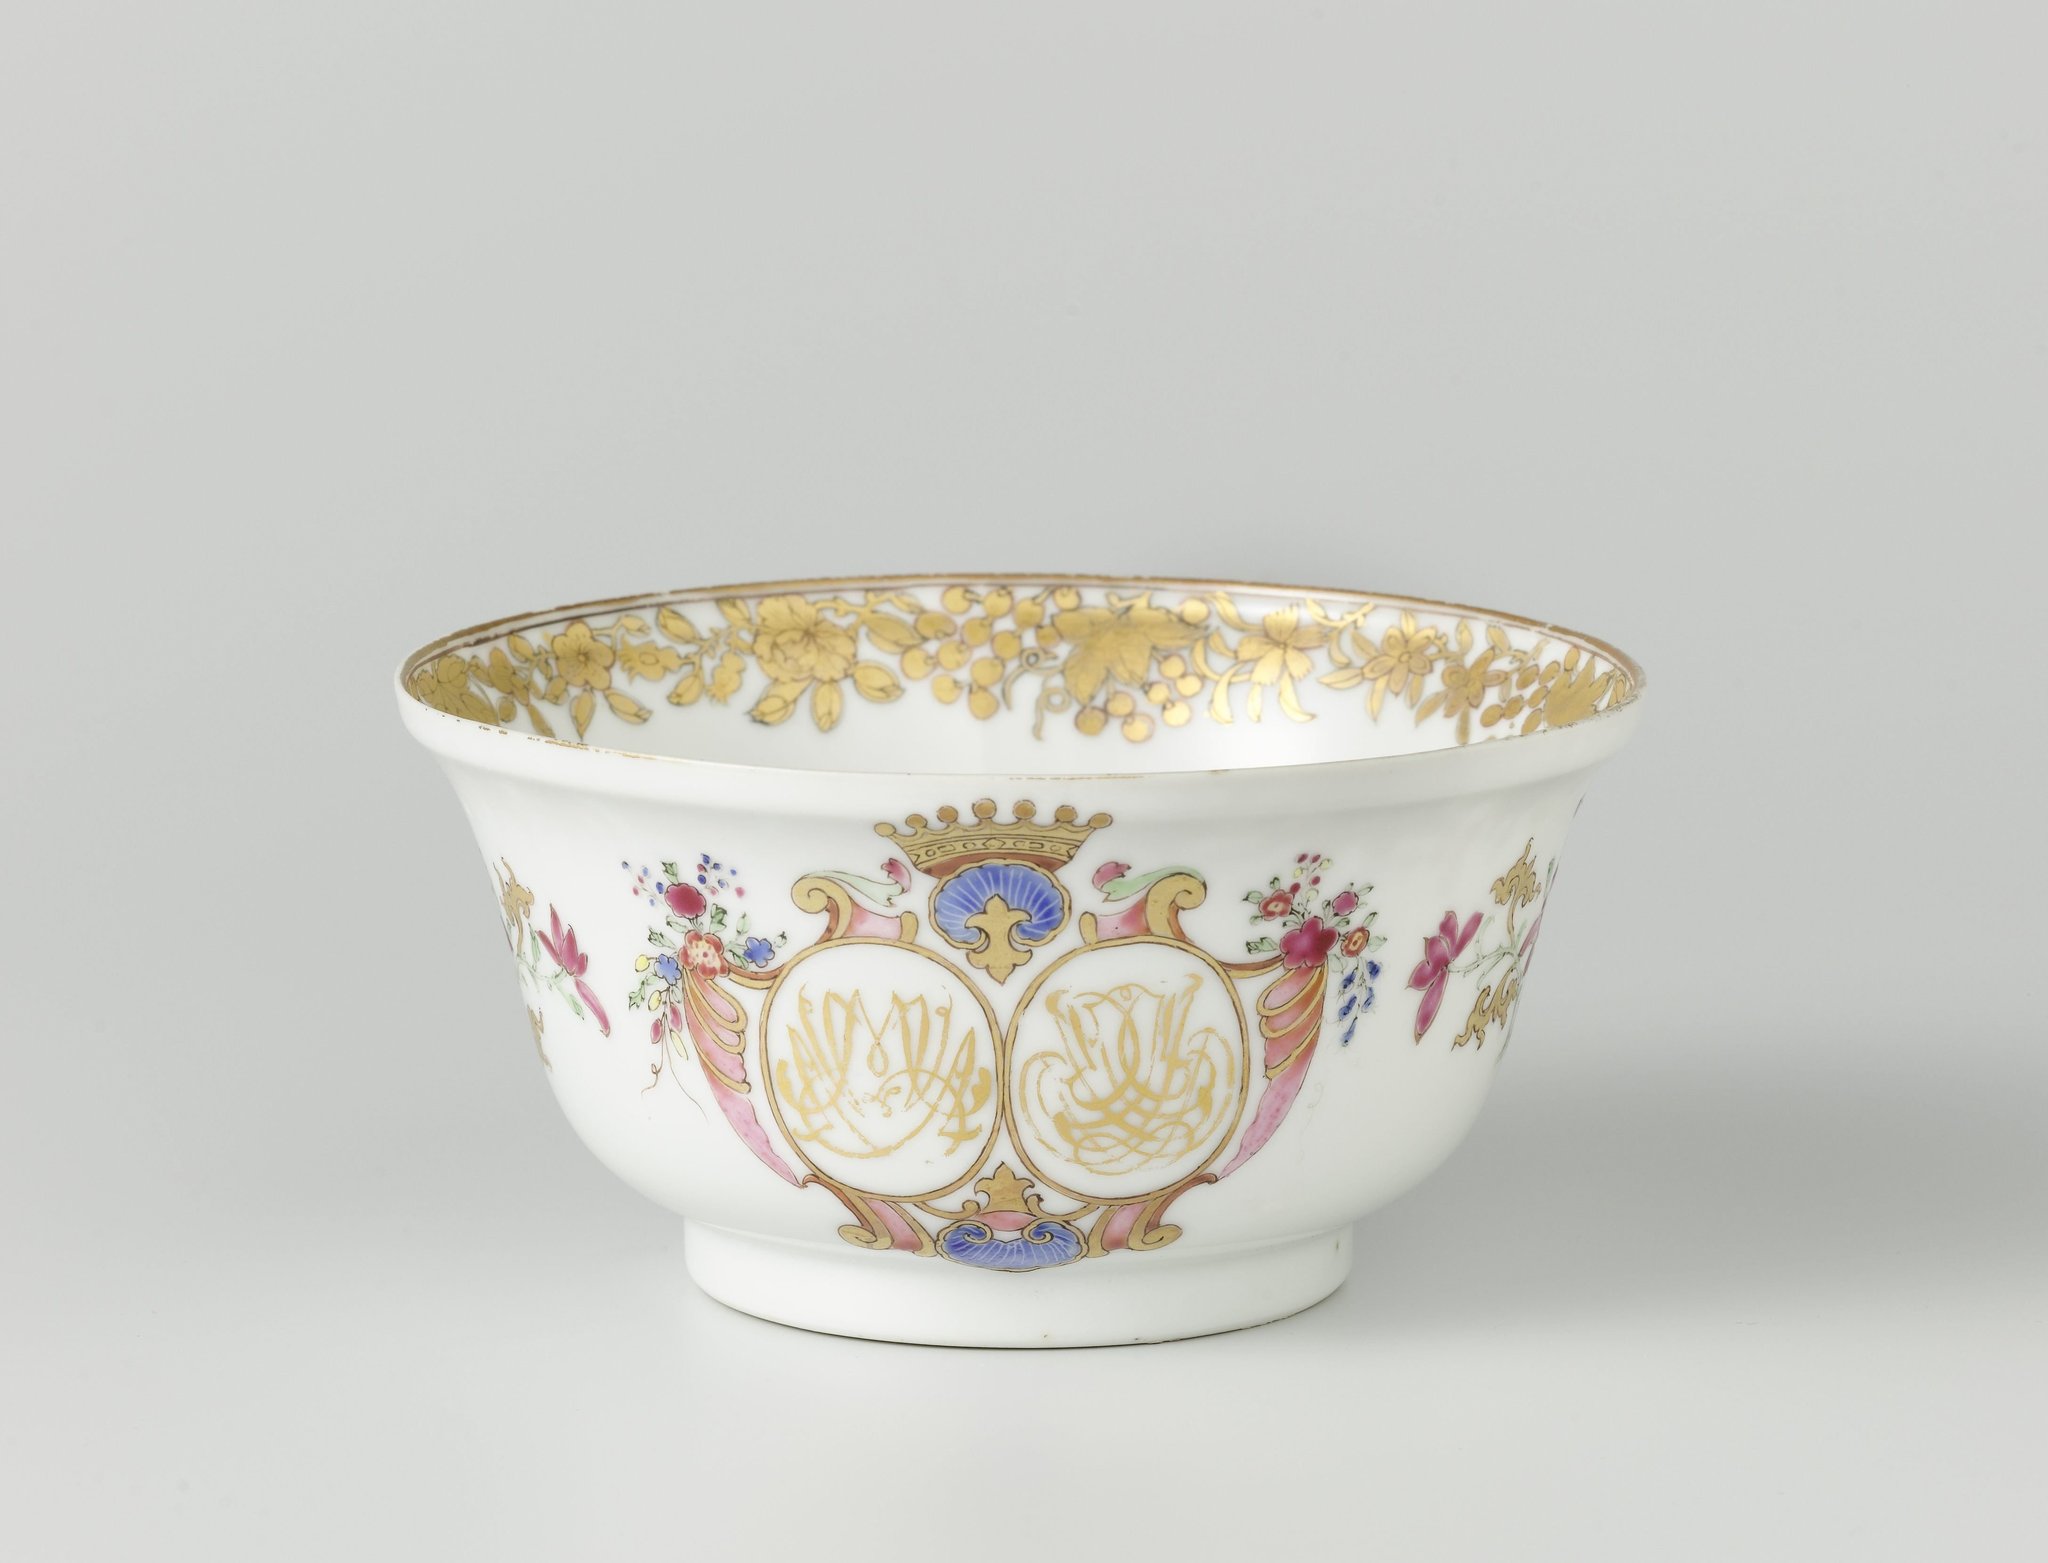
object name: sugar box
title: Bell-shaped bowl from the 'Swellengrebel service' with a double crowned monogram and a border with floral scrolls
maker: Anonymous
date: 1740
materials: glaze, gold, paint, porcelain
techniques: firing, gilding, turning, vitrification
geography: china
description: De monogrammen 'MVA' en 'CHTD' staan voor Maurits van Aerden (1694-1746) en Constantia Helena ten Damme (1694-1772), getrouwd in 1716. Het servies is waarschijnlijk besteld ter ere van hun vijfentwingtigjarig huwelijksjubileum in 1741. (Campen, Jan van & Hartkamp-Jonxis, Ebeltje, Aziatische weelde : VOC-kunst in het Rijksmuseum, Zutphen 2011, p. 78)